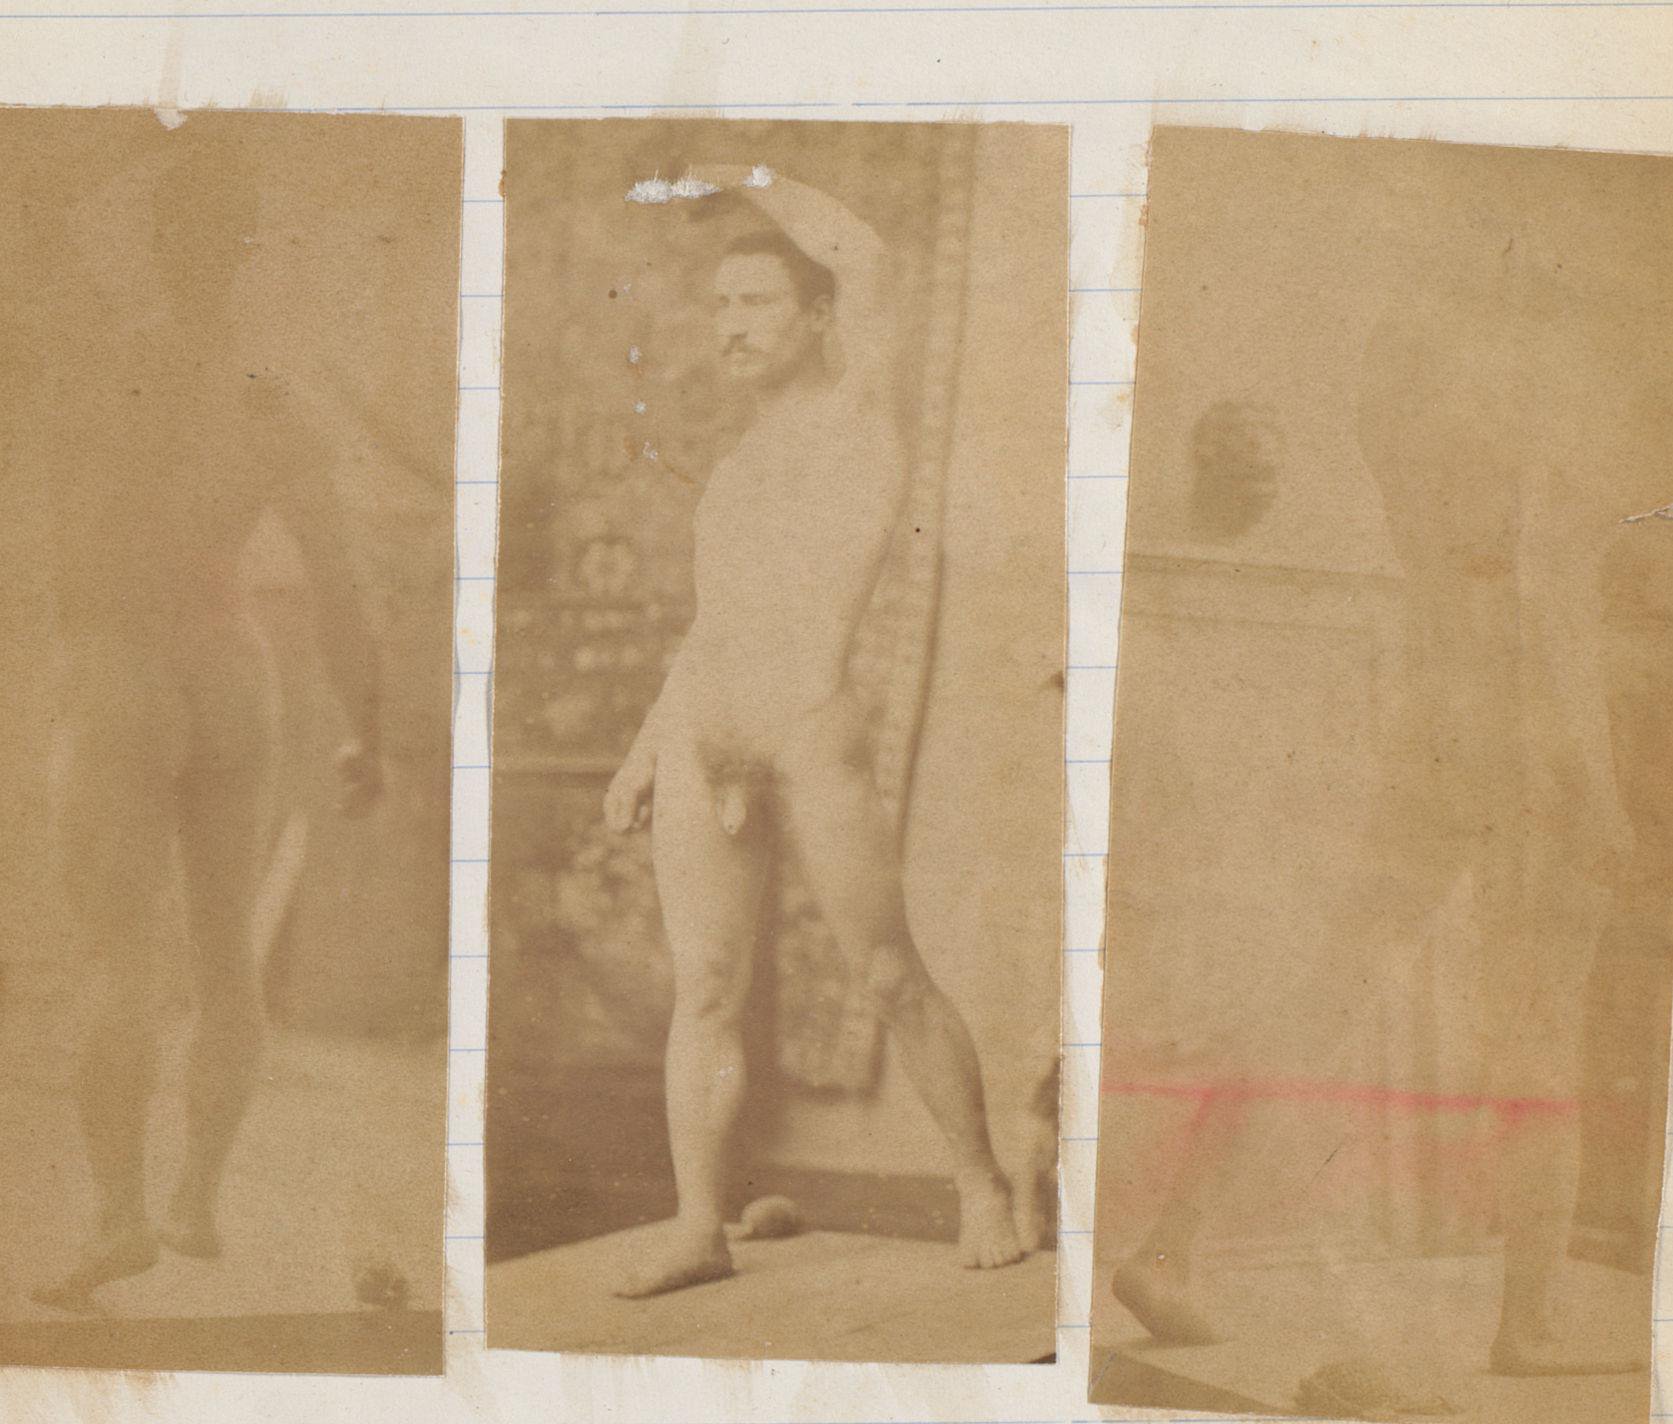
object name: album leaf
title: Studie van een mannelijk naaktmodel, rechtop staand en schuin van voren gezien, in het atelier van Jacques de Lalaing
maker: jacques lalaing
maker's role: painter, sculptor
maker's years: 1858-1917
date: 1883-1890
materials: photographic support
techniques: albumen print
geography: brussels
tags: the (nude) human figure; 'corpo humano' (ripa) (+ front view), adult man, artist (in general) working from nude model